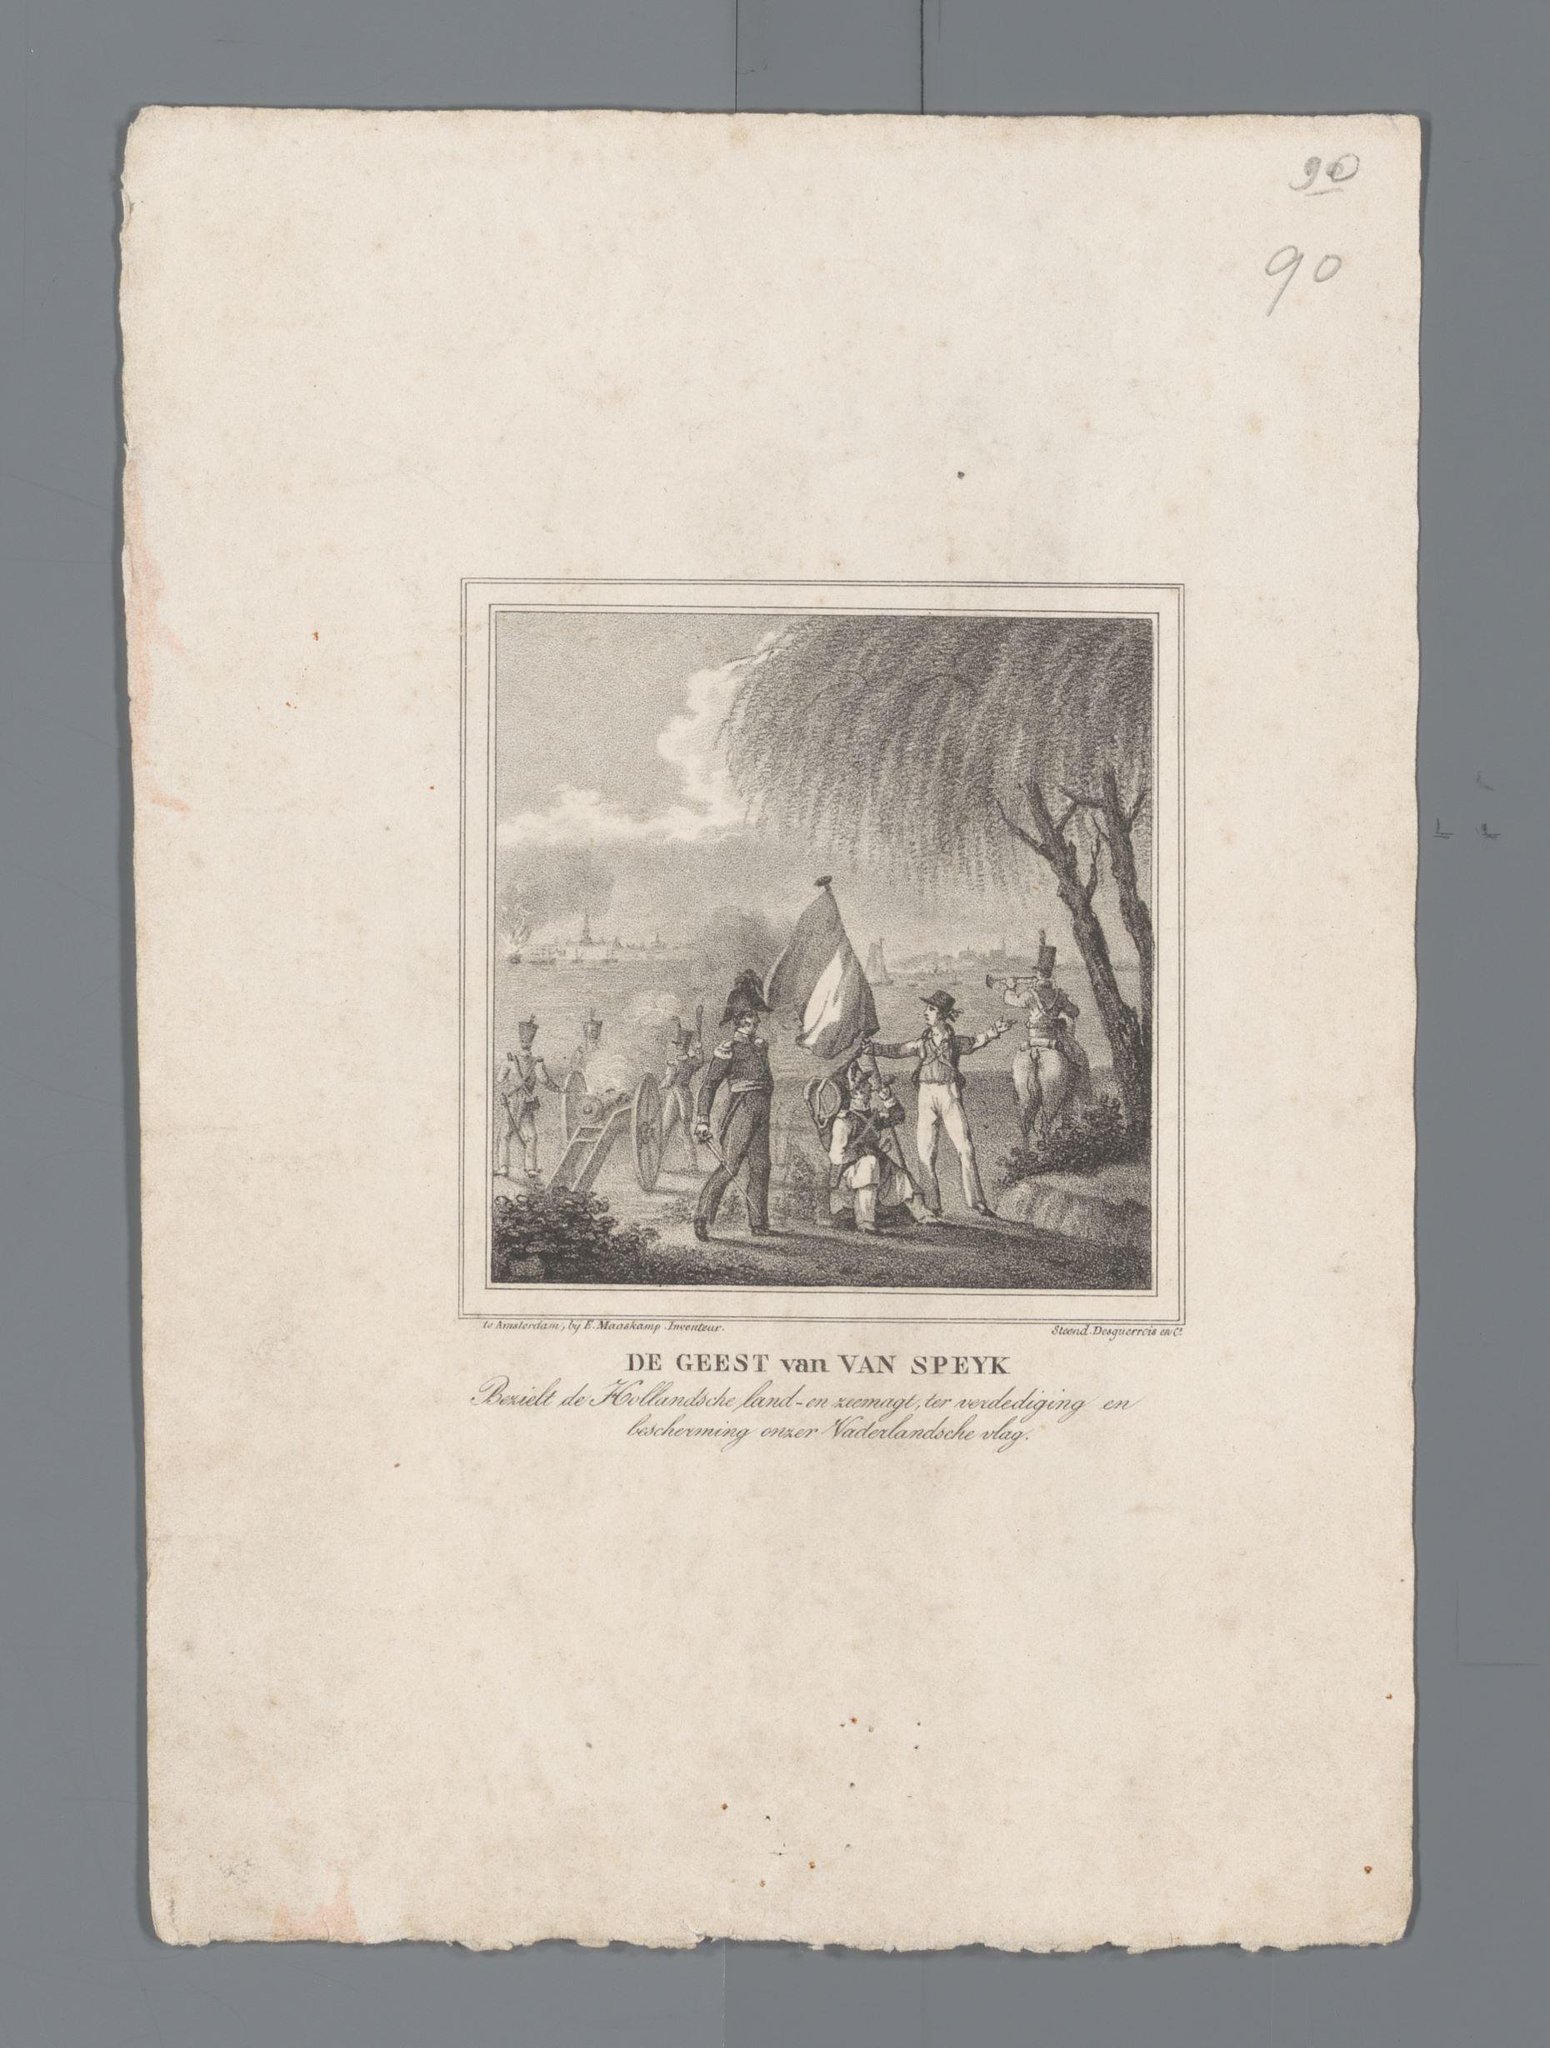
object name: print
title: De Geest van Jan van Speyk, 1831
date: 1831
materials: paper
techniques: lithograph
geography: amsterdam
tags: antwerp, jan van speyk, battle, fighting in general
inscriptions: caption: ‘DE GEEST van VAN SPEYK / Bezielt de Hollandsche land-en zeemagt, ter verdediging en / bescherming onzer Vederlandsche vlag.’, signature: ‘te Amsterdam, bij E. Maaskamp. Inventeur.’, signature: ‘Steend. Desguerrois en Co.’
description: Verschillende militairen in een landschap. In de ruimte tussen de figuren is de verstopte gestalte van Jan van Speyk te ontwaren. In de verte het in de lucht springen van de kanonneerboot van Jan van Speyk op de Schelde voor Antwerpen op 5 februari 1831.